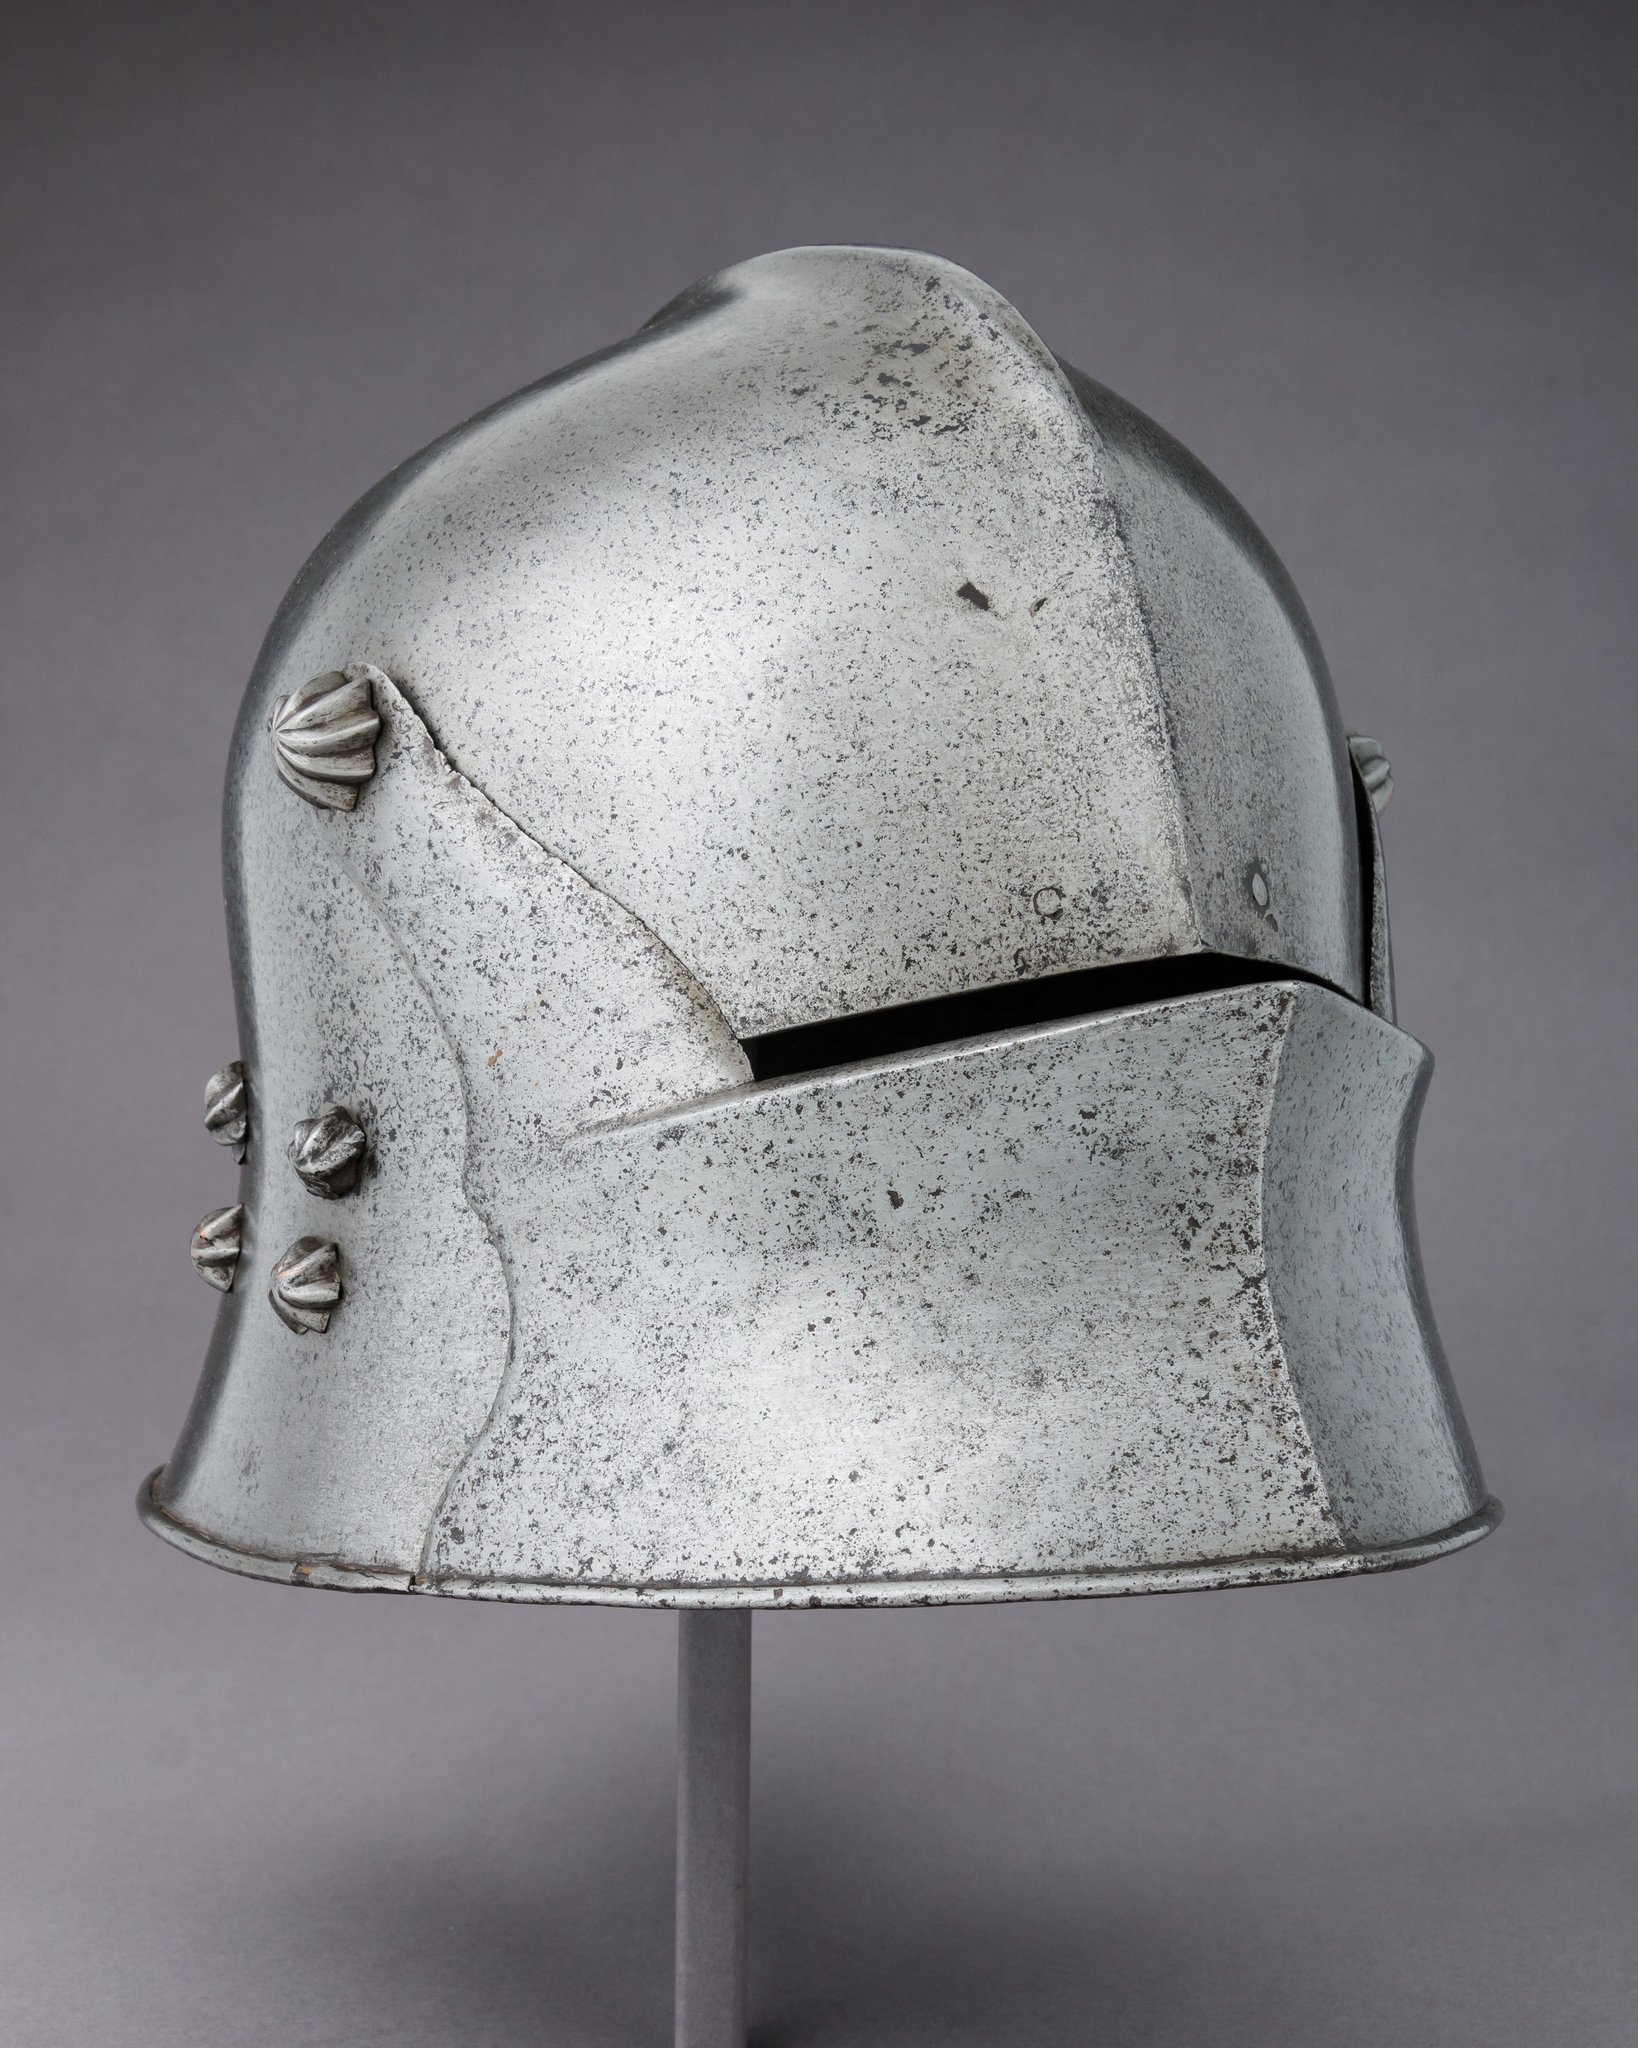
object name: sallet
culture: german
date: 1475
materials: steel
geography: germany